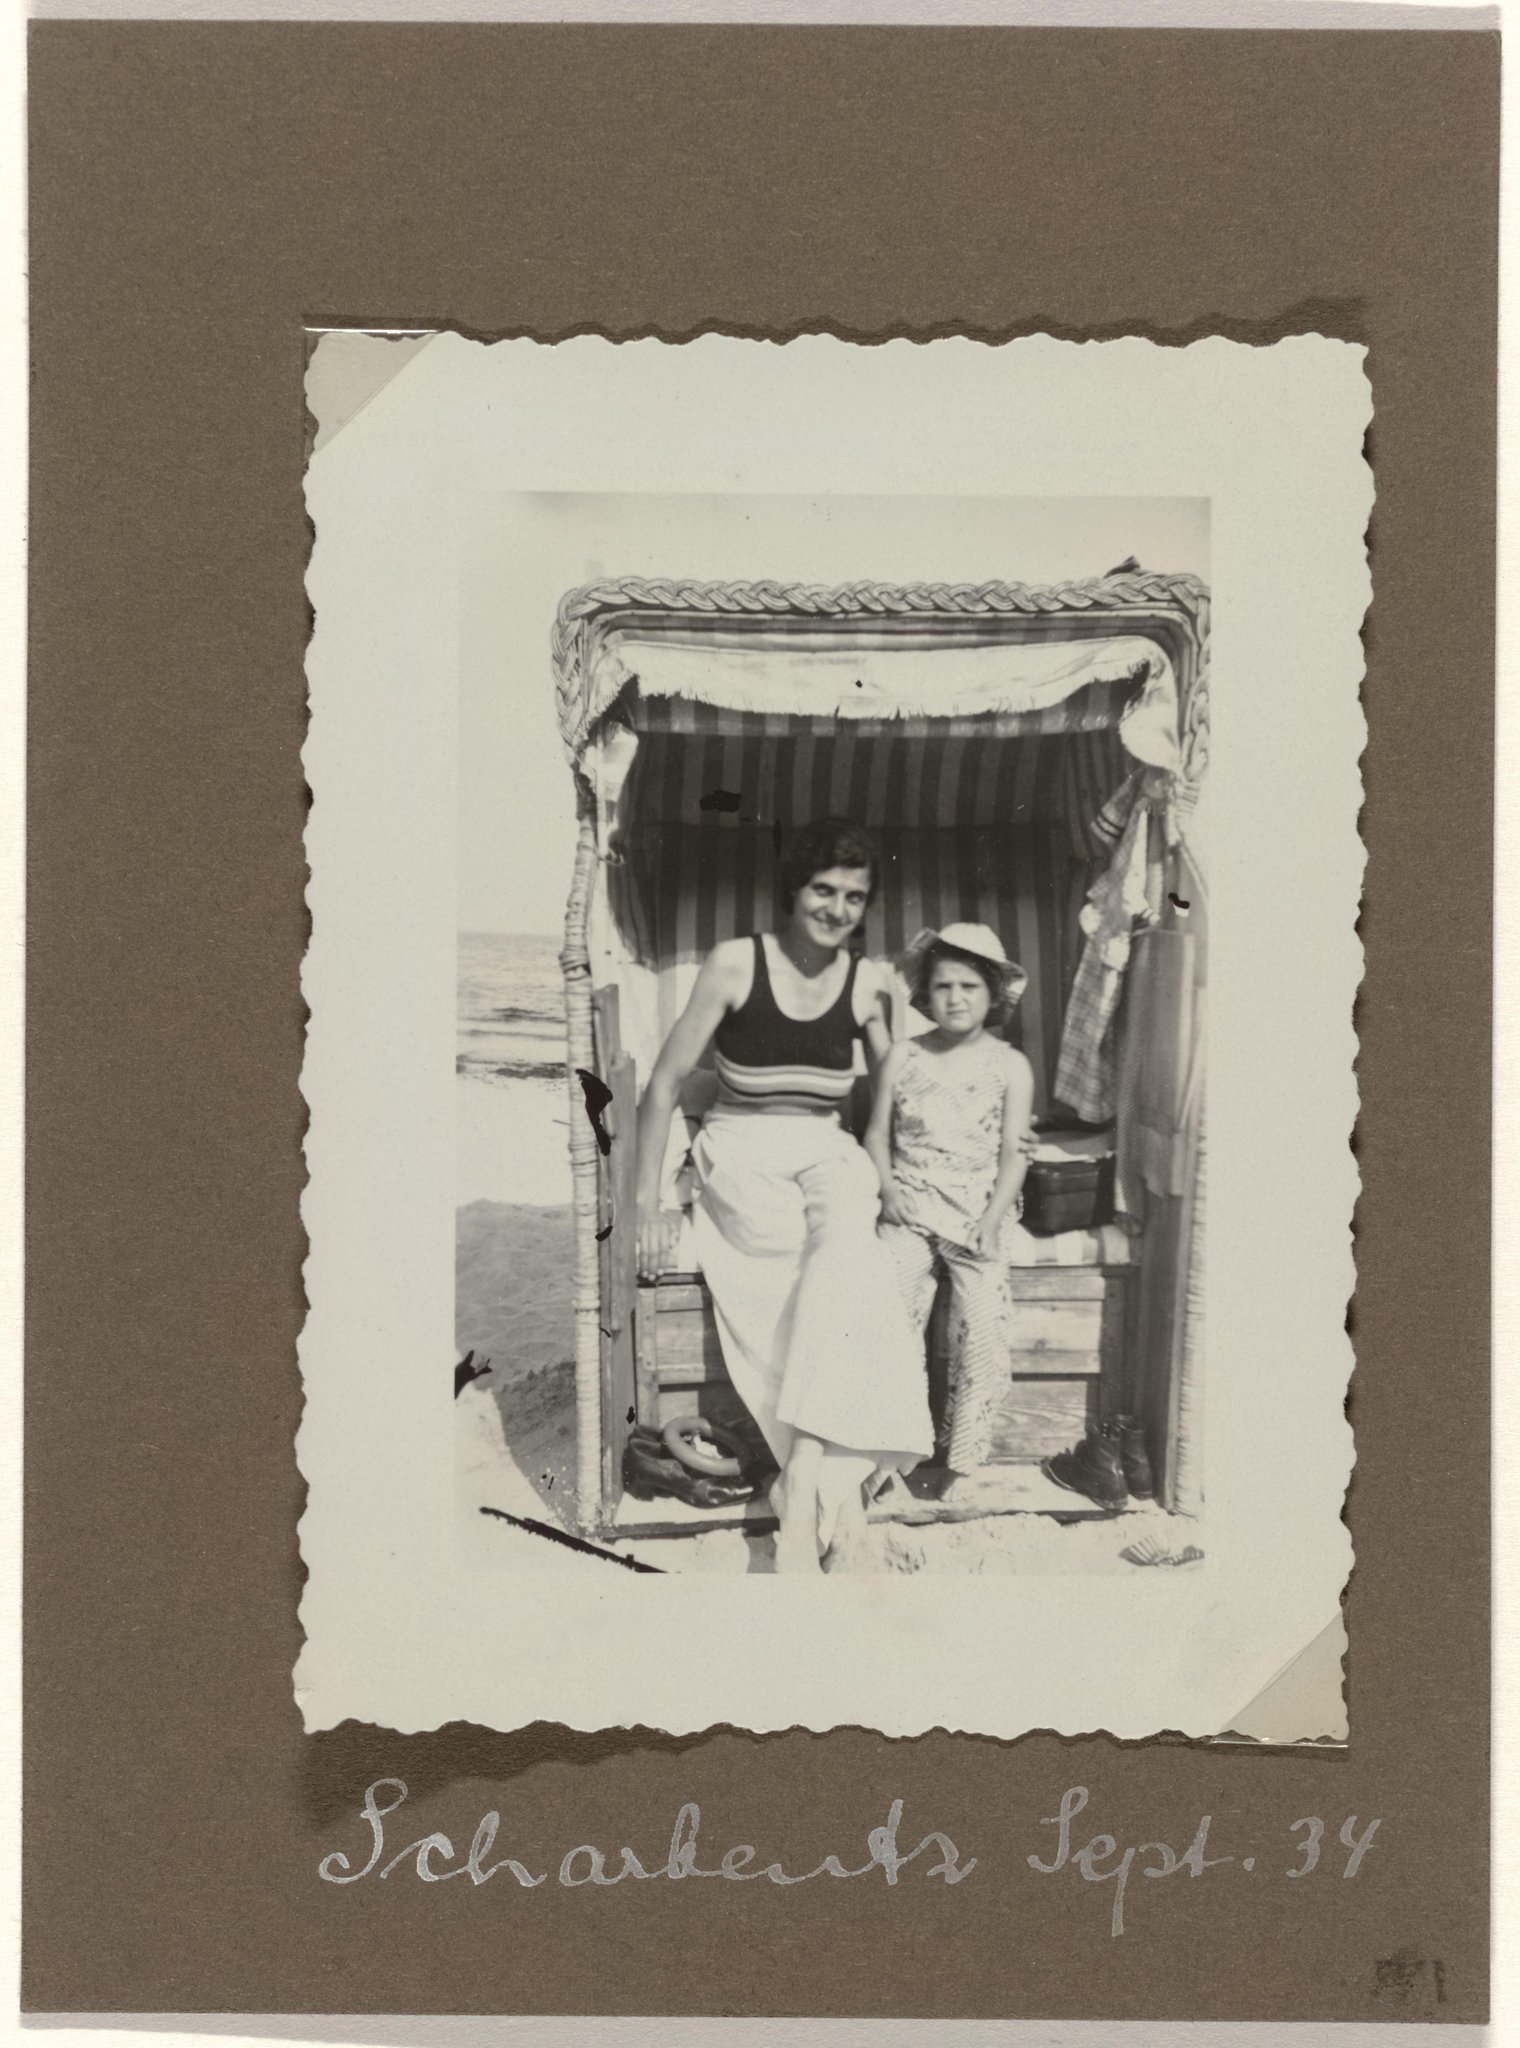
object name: photograph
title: Isabel Wachenheimer met onbekend lid van de huishoudelijke staf in een strandkorf op het strand van Scharbeutz, september 1934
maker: Anonymous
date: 1909-1934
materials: photographic support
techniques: gelatin silver print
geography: scharbeutz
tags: leiden, isabel wachenheimer-elon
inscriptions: inscription: ‘Scharbeutz Sept.34’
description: Dit object is onderdeel van de nalatenschap van Isabel Elon-Wachenheimer (1928-2010). Tot haar overlijden behoorde het samen met de andere objecten uit de nalatenschap tot haar privédomein van Isabel Wachenheimer. In die particuliere context zijn deze objecten tezamen en individueel aandenkens - aan de jeugd, ouders en familie van Isabel Wachenheimer vóór en tijdens de Shoah en aan haar leven na de Tweede Wereldoorlog. Isabel Wachenheimer, die van juni 1943 tot mei 1945 gevangen zat in Kamp Westerbork, Theresienstadt, Auschwitz, Lenzing a/d Oberdonau (een buitenkamp van Mauthausen), overleefde de Shoah. Haar ouders – Eugène Wachenheimer en Else Wachenheimer-Moos - werden op 14 oktober 1944 in Auschwitz-Birkenau vermoord.